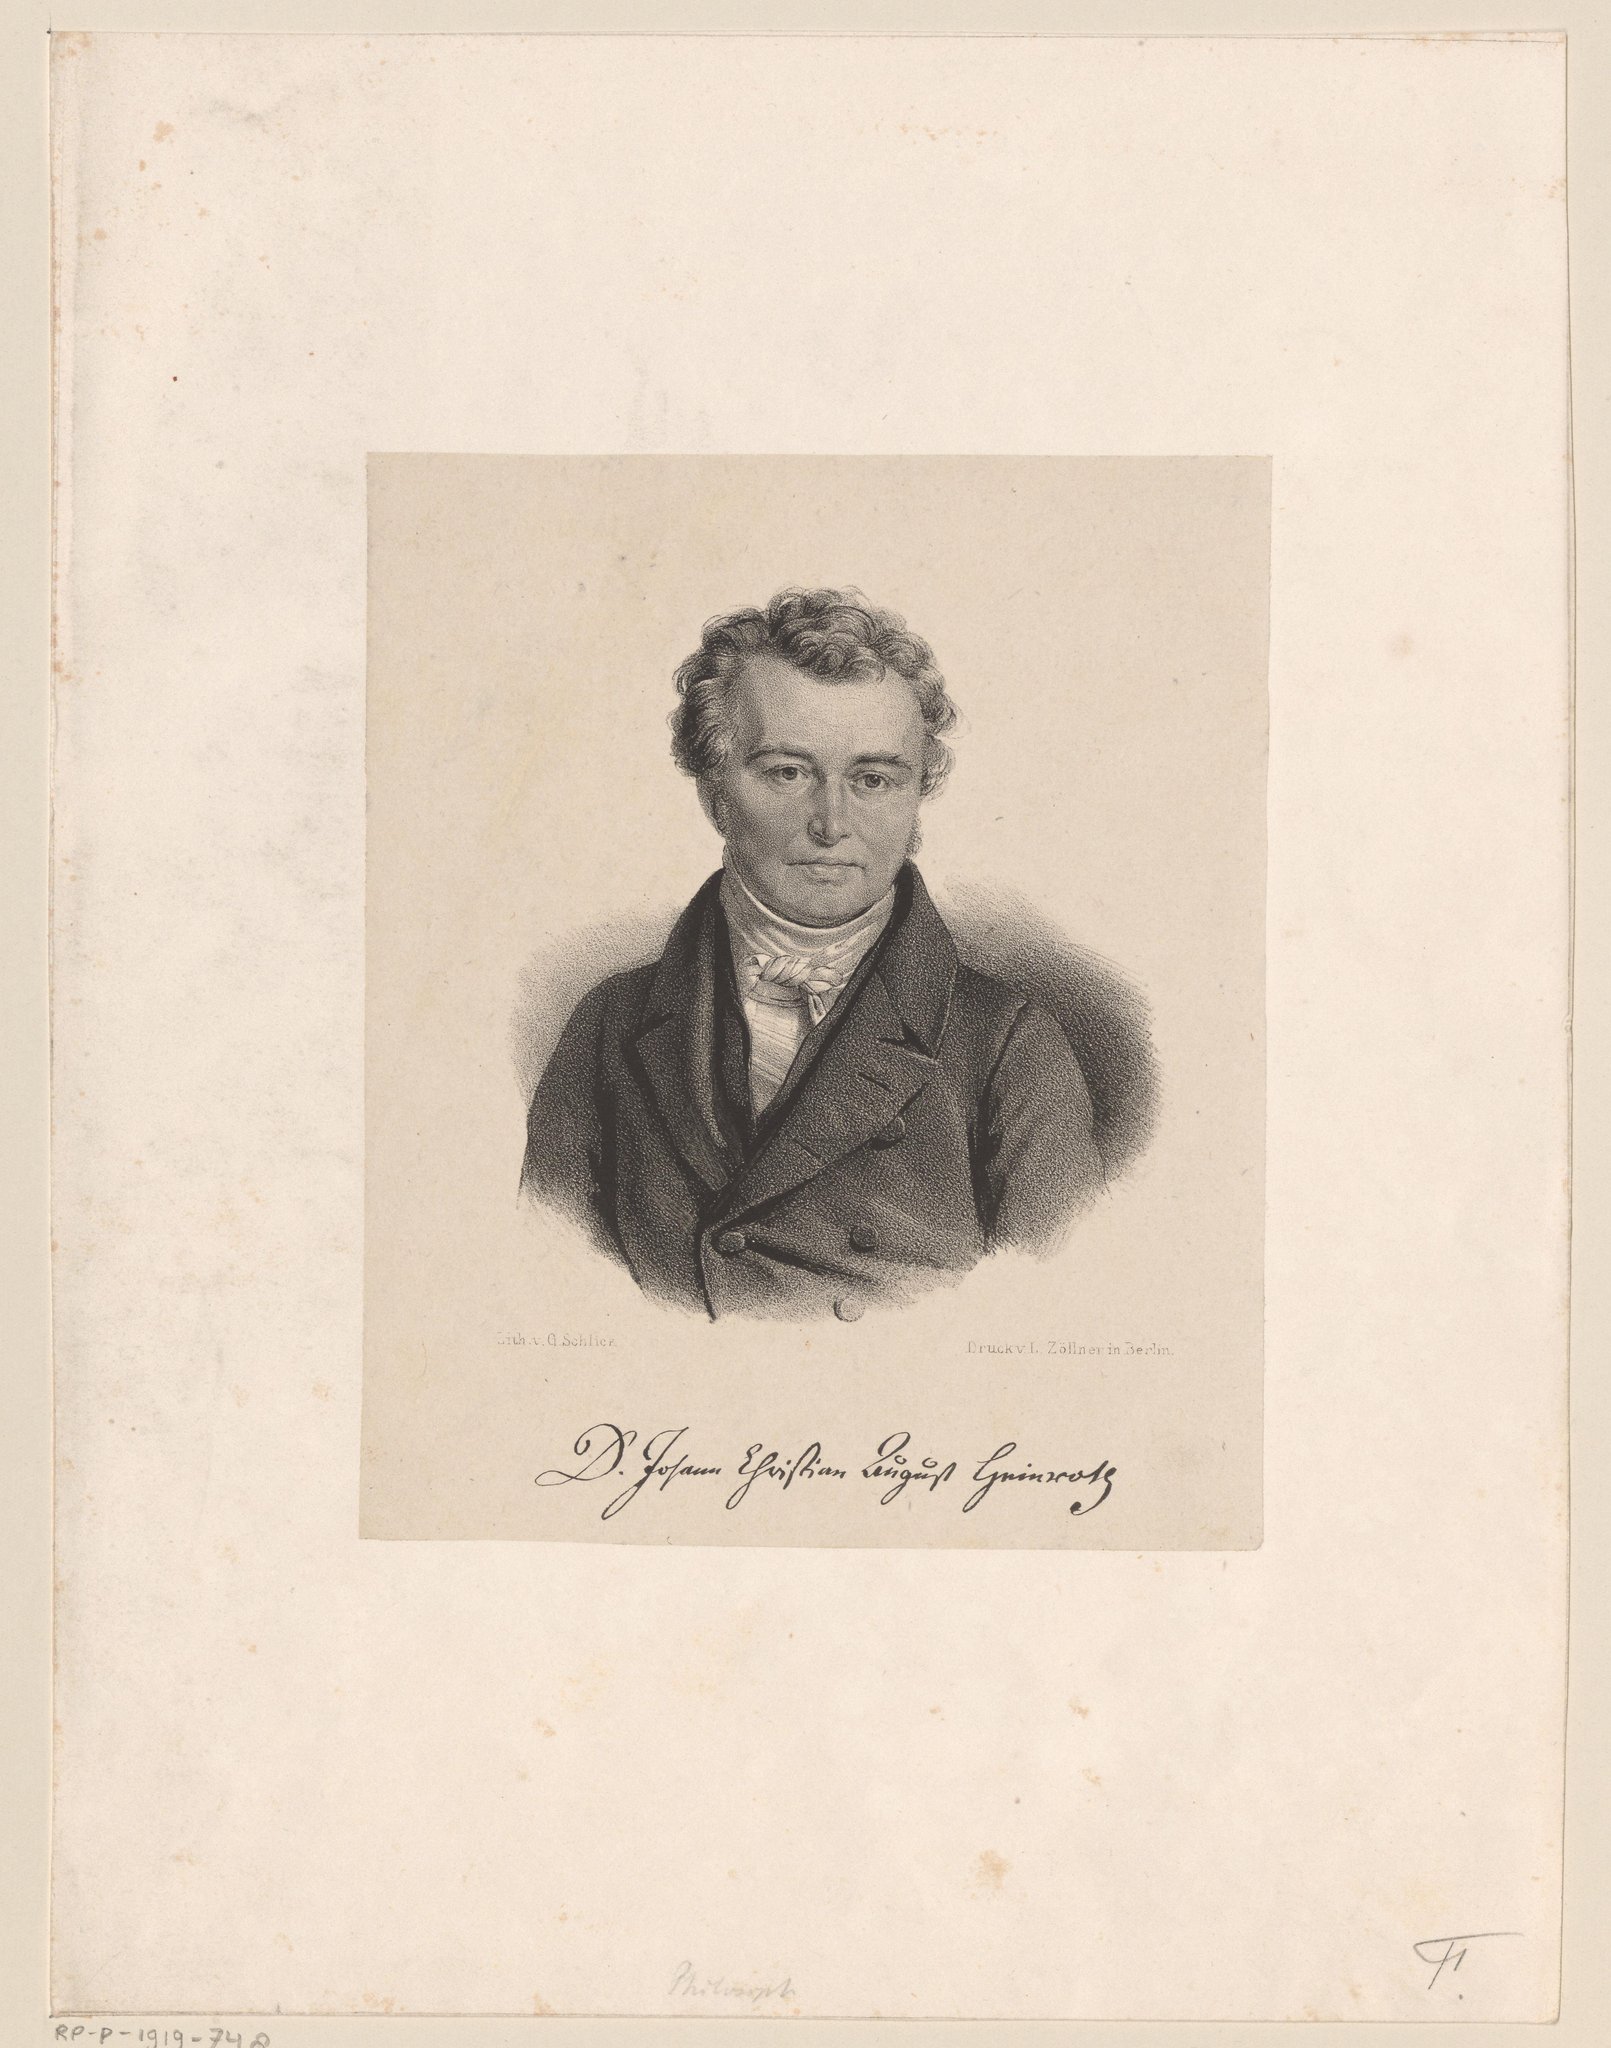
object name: print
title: Portret van Johann Christian August Heinroth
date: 1814-1869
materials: paper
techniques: lithograph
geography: berlin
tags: historical persons, physician, doctor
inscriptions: collector's mark: Lugt 2228